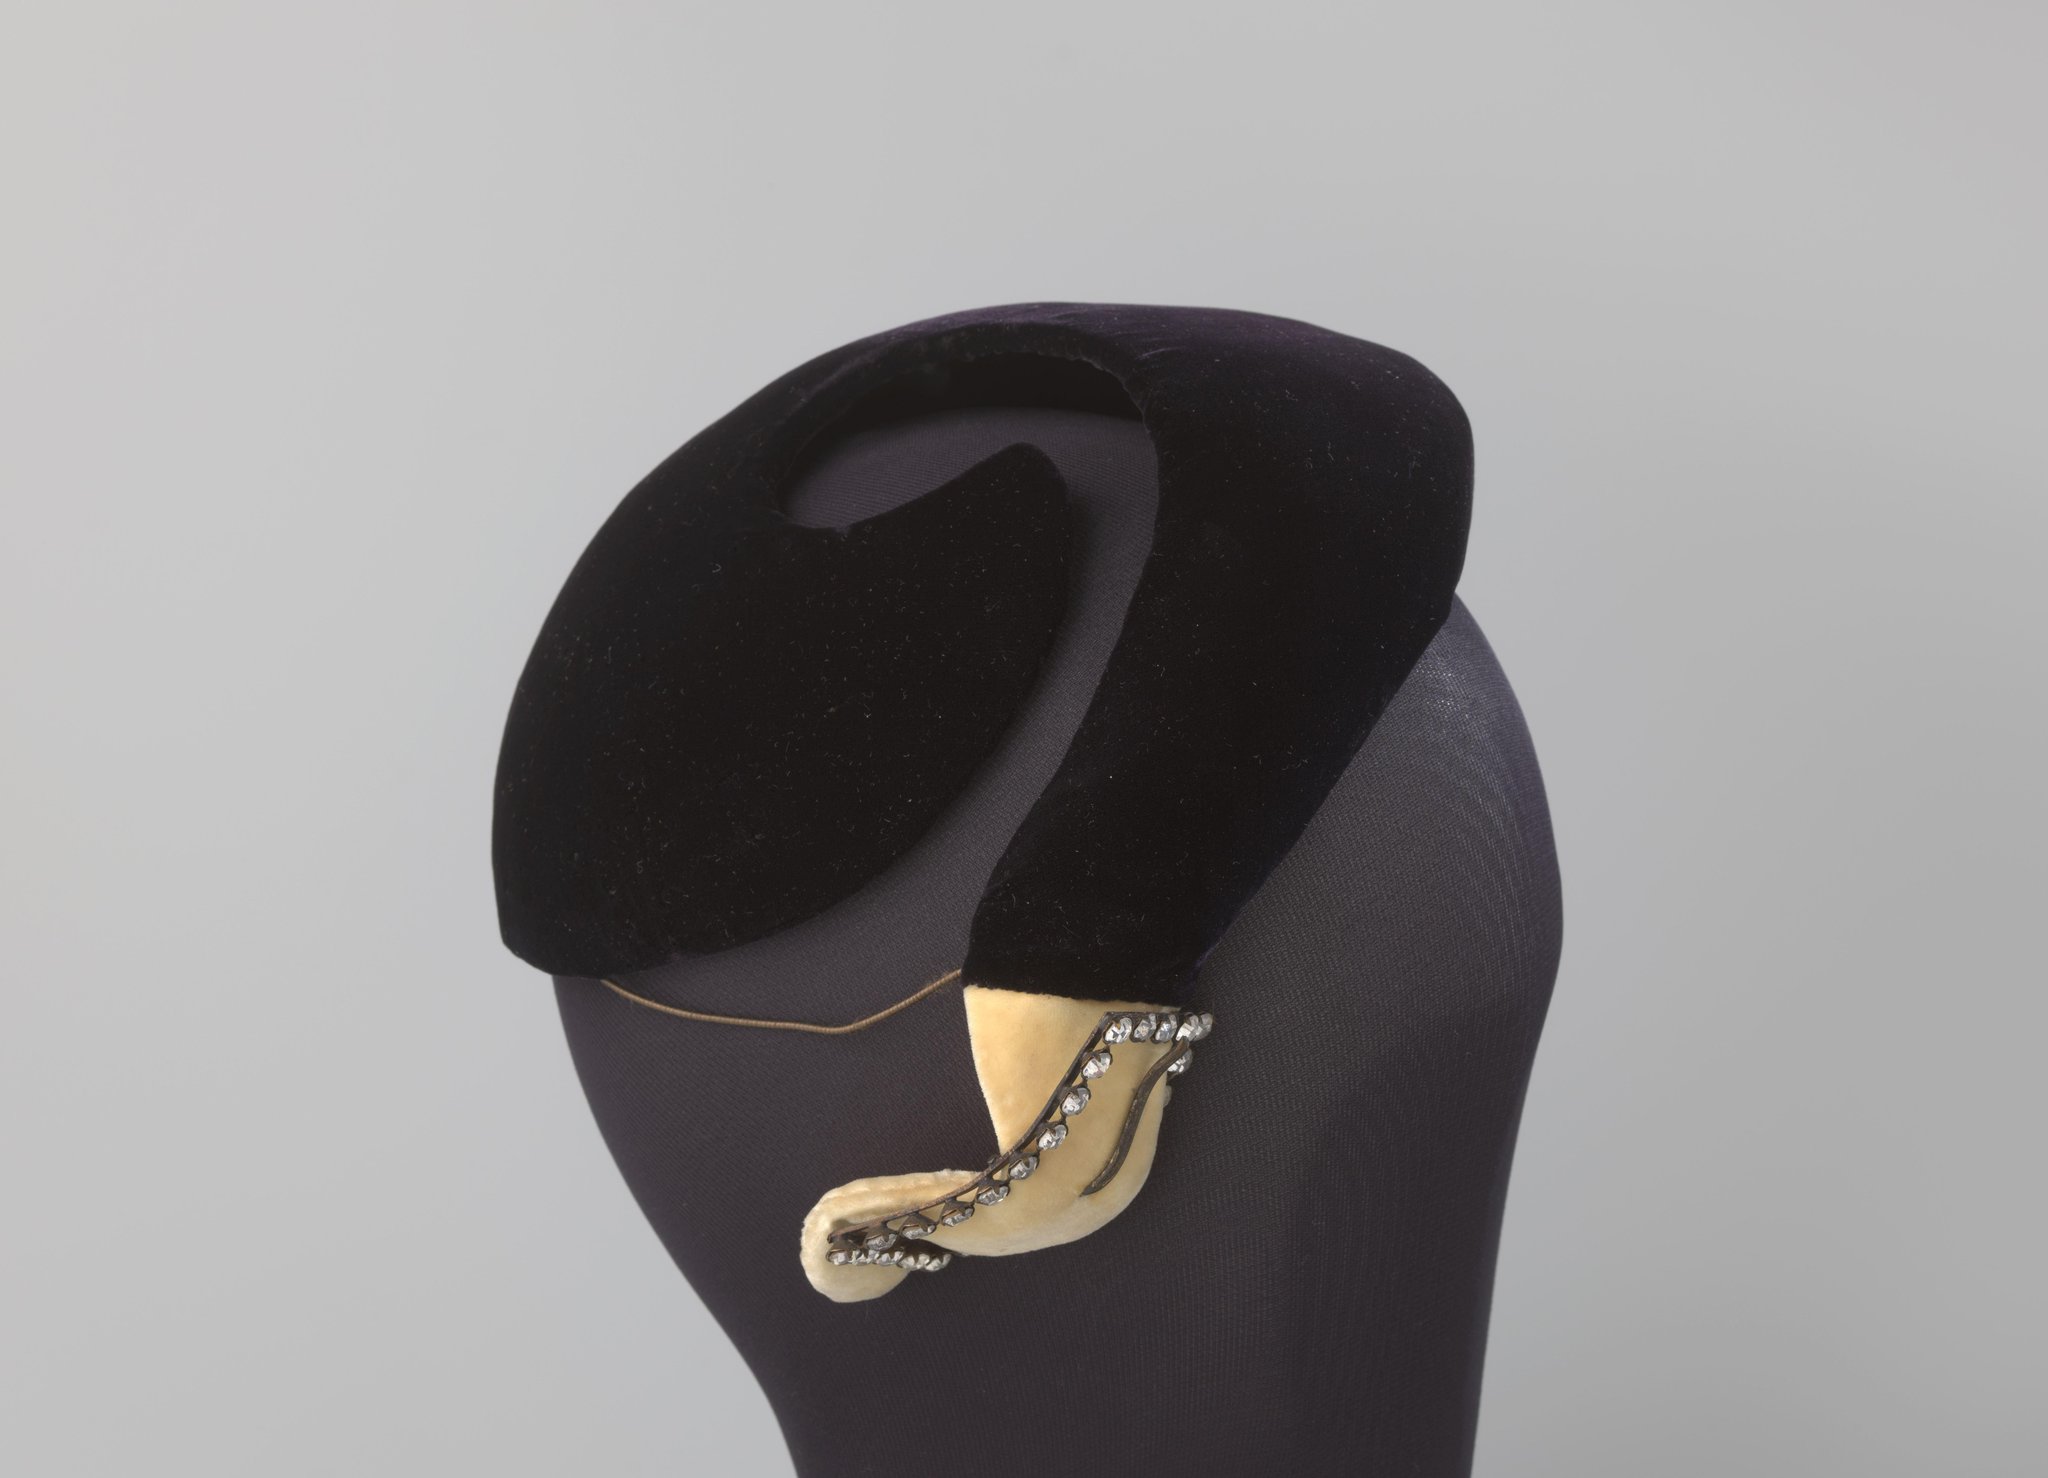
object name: bibi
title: Bibi van zwart en wit fluweel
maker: paulette modes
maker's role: hoedenmaakster, modiste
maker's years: 1900-1984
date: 1948-1952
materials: velvet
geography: paris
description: Kapje (zgn. bibi) van zwart en wit fluweel, open spiraalvorm eindigend in wit fluweel met een met strasstenen versierde gesp.